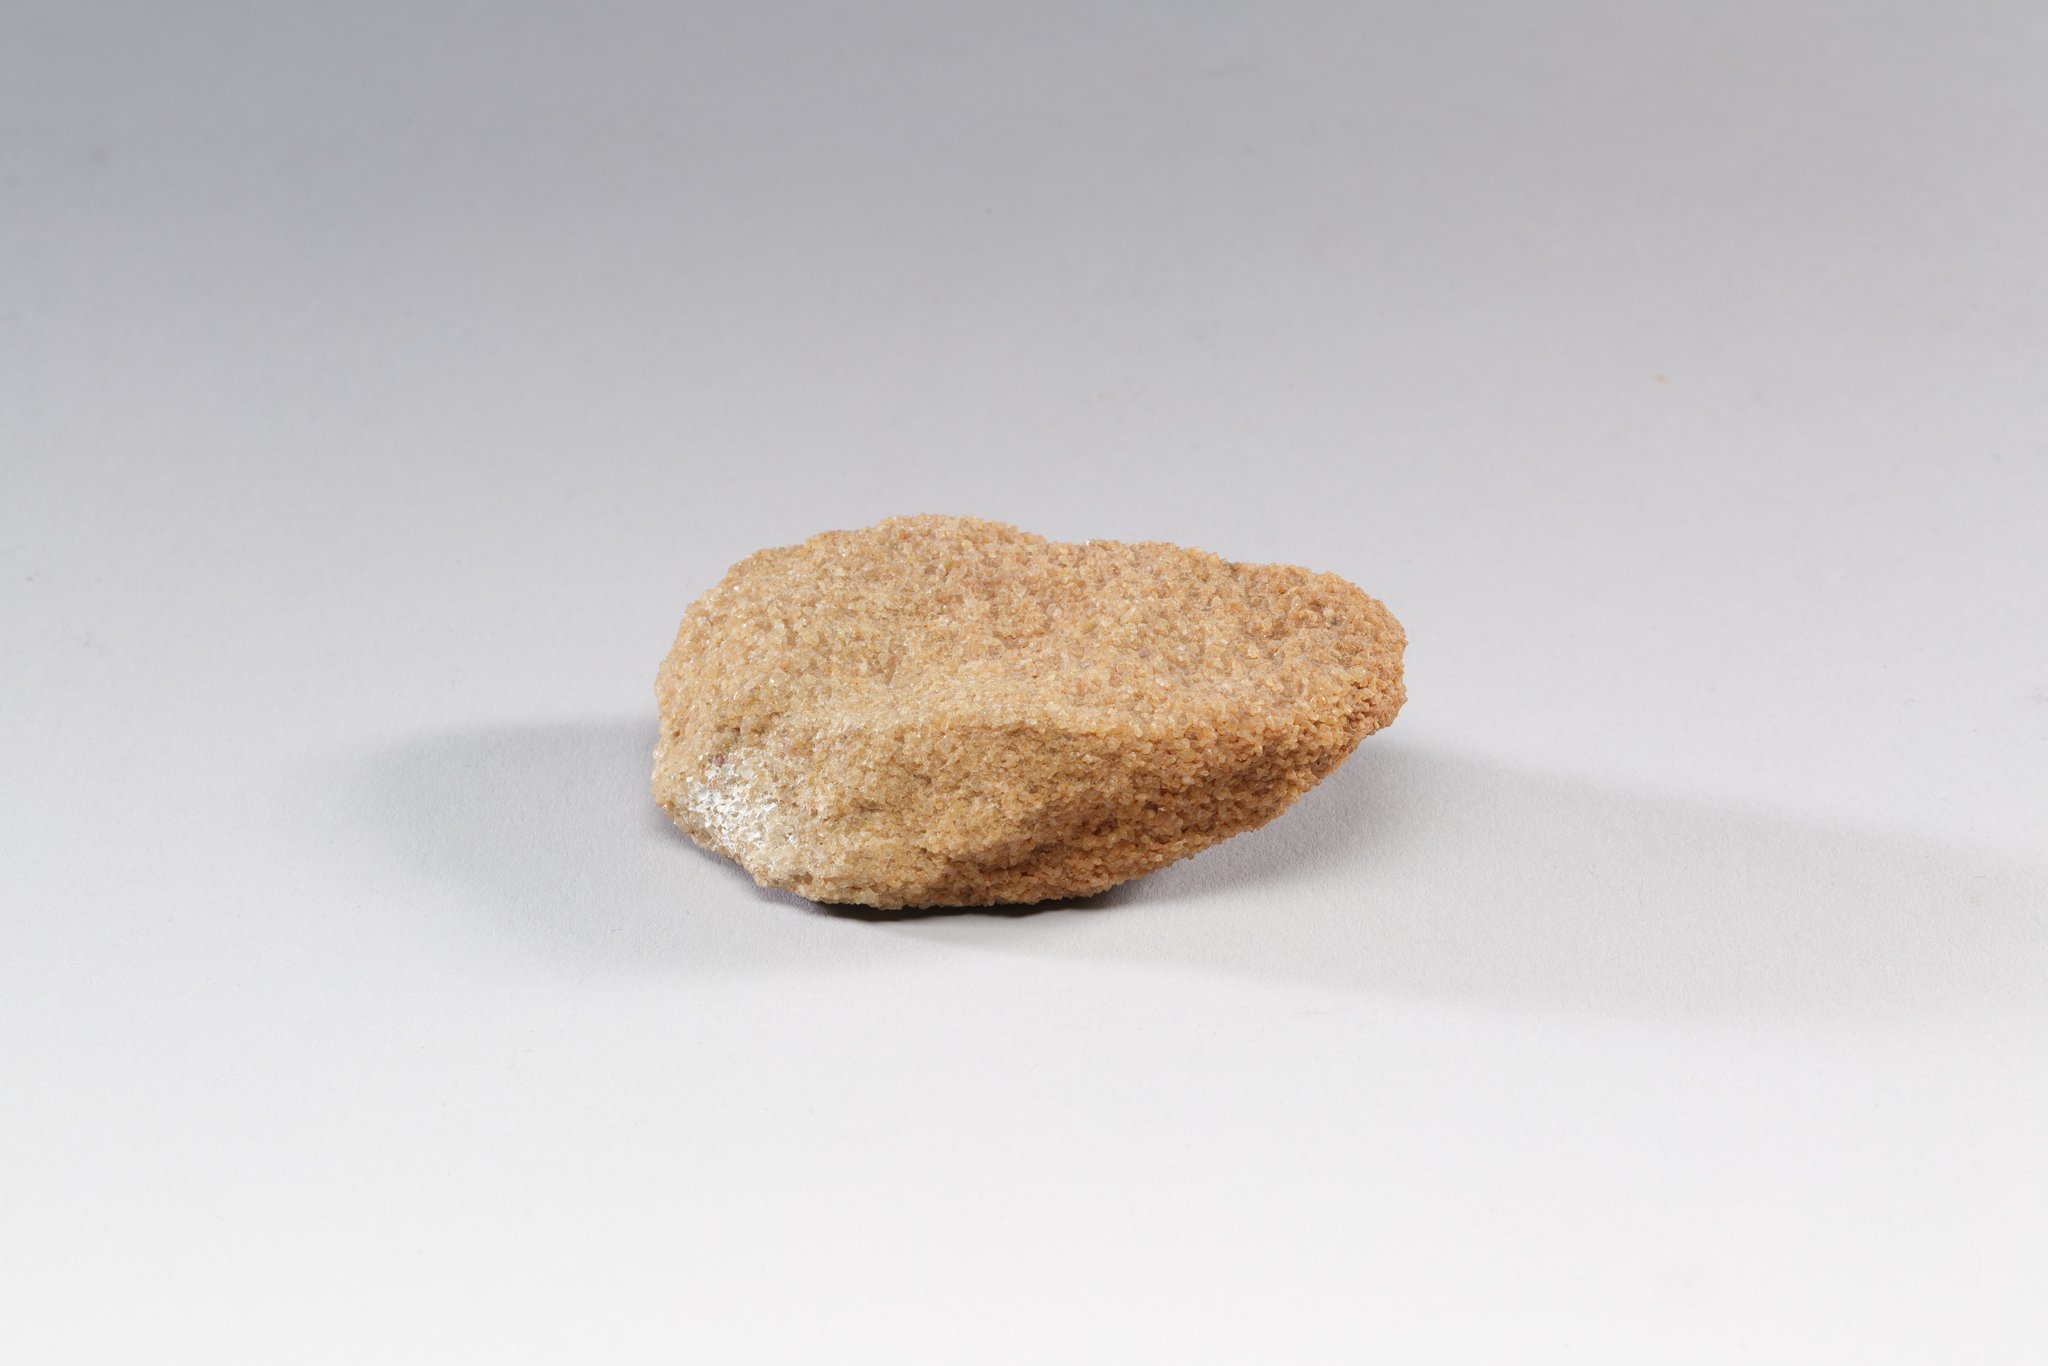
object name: rubbing stone, tool, senenmut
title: Rubbing Stone (?)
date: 1479-1458 BCE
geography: egypt